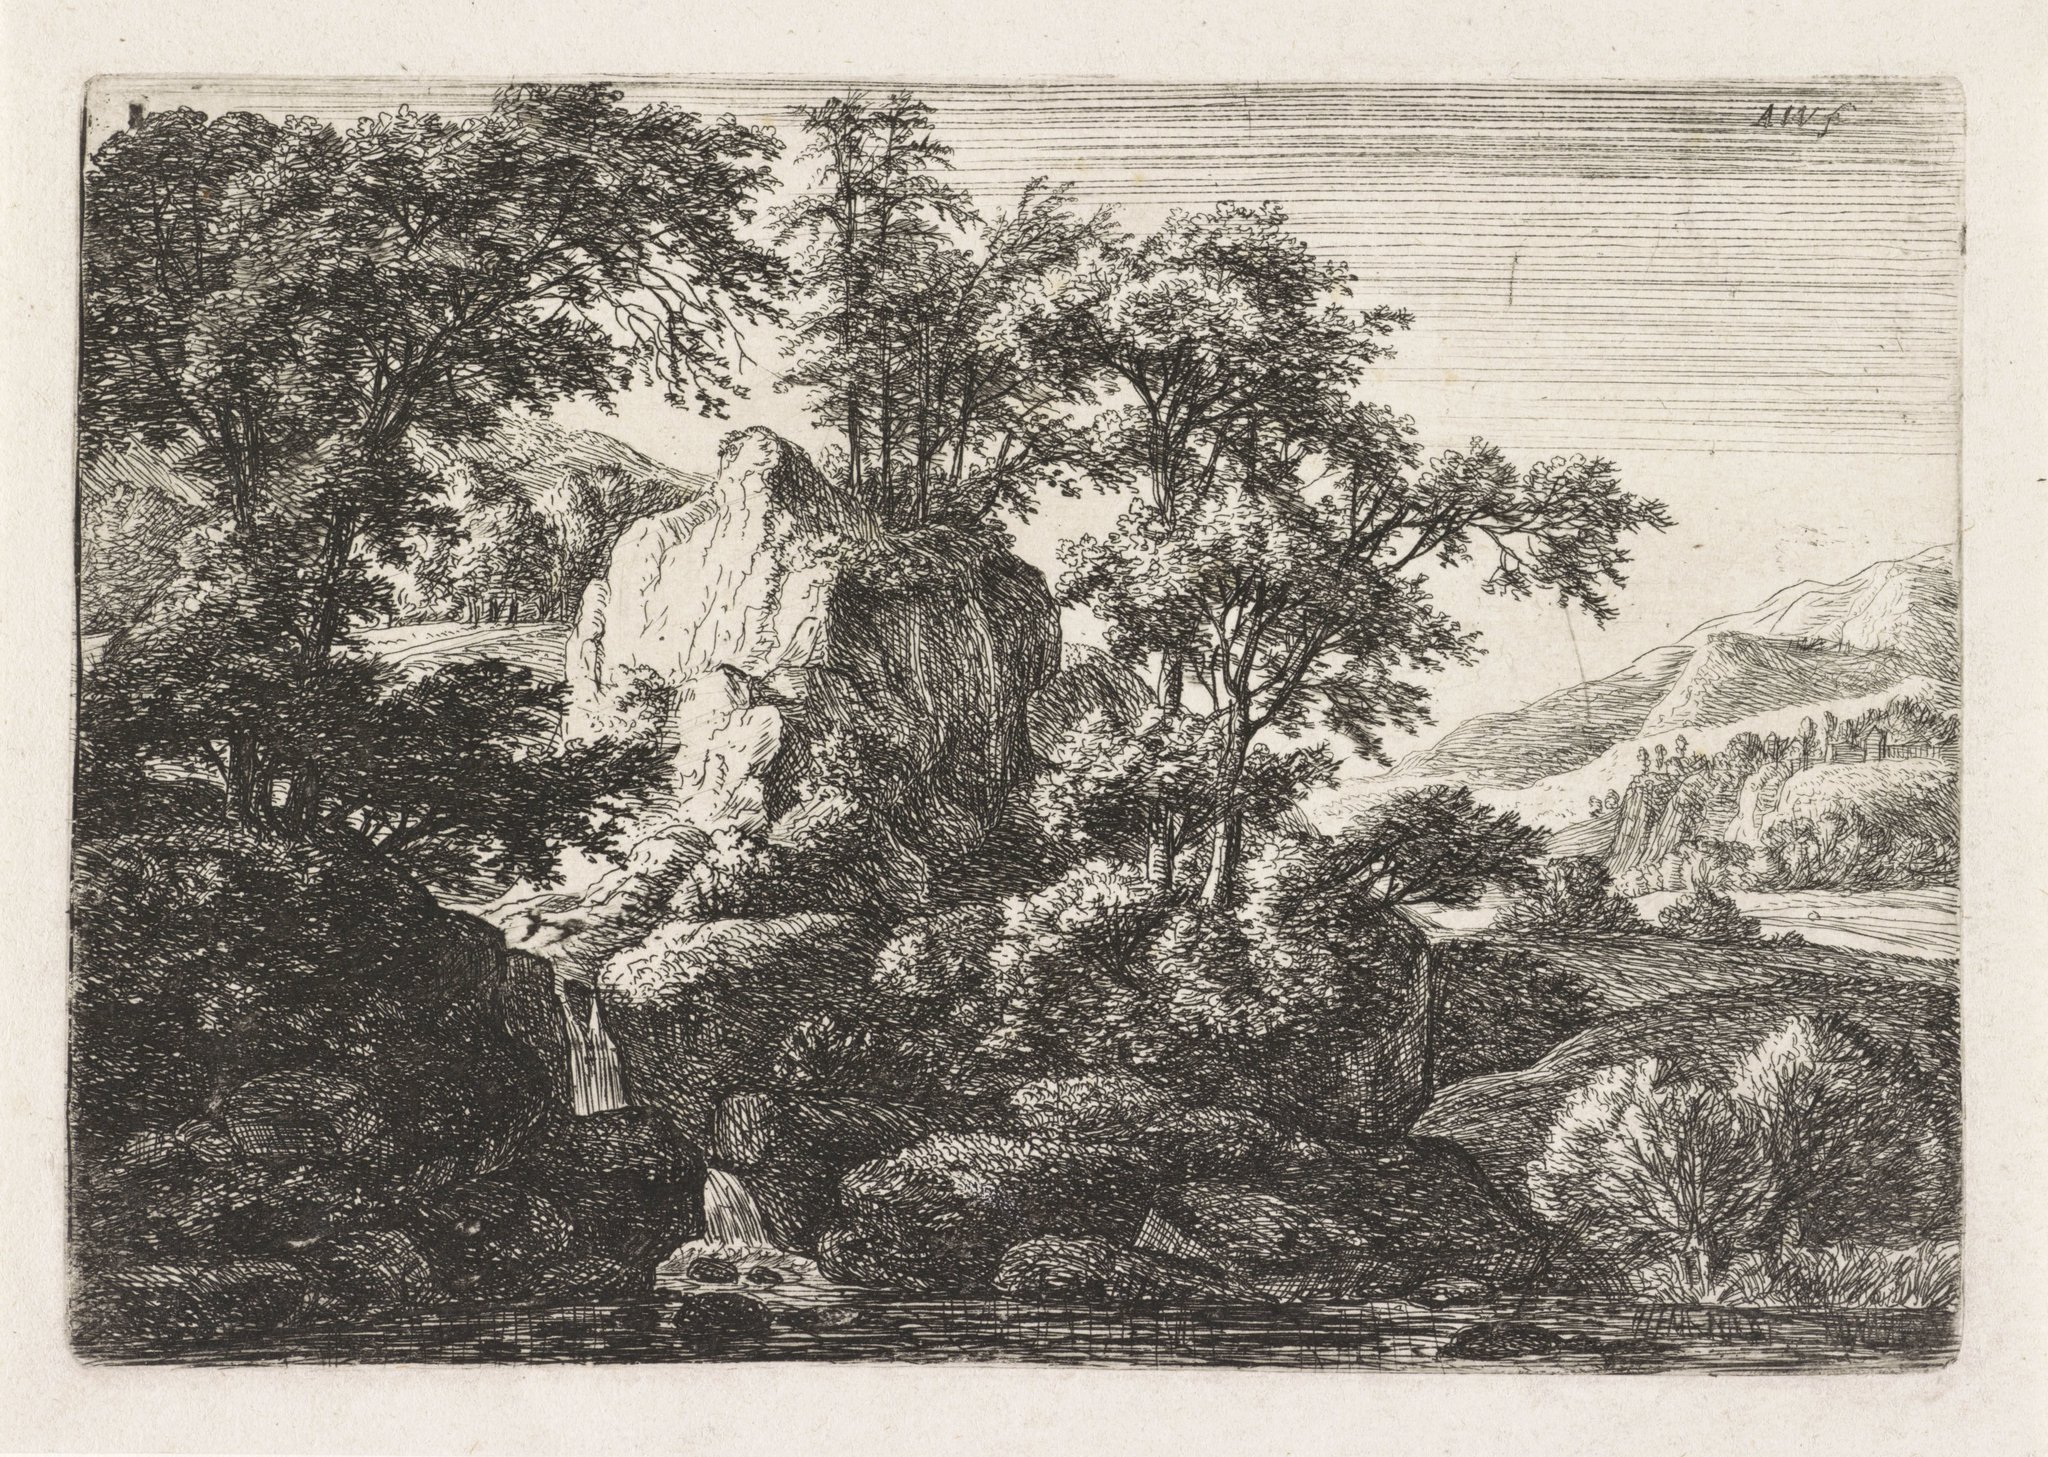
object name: print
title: Landschappen met rotspartijen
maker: anthonie waterloo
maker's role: draughtsman, painter, print maker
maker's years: 1609-1690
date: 1630-1663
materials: paper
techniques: etching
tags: waterfall, rock-formations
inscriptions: collector's mark: Lugt 240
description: Links stroomt een dubbele waterval over met bomen begroeide rotsen. Rechts in de verte zijn bergen te zien.